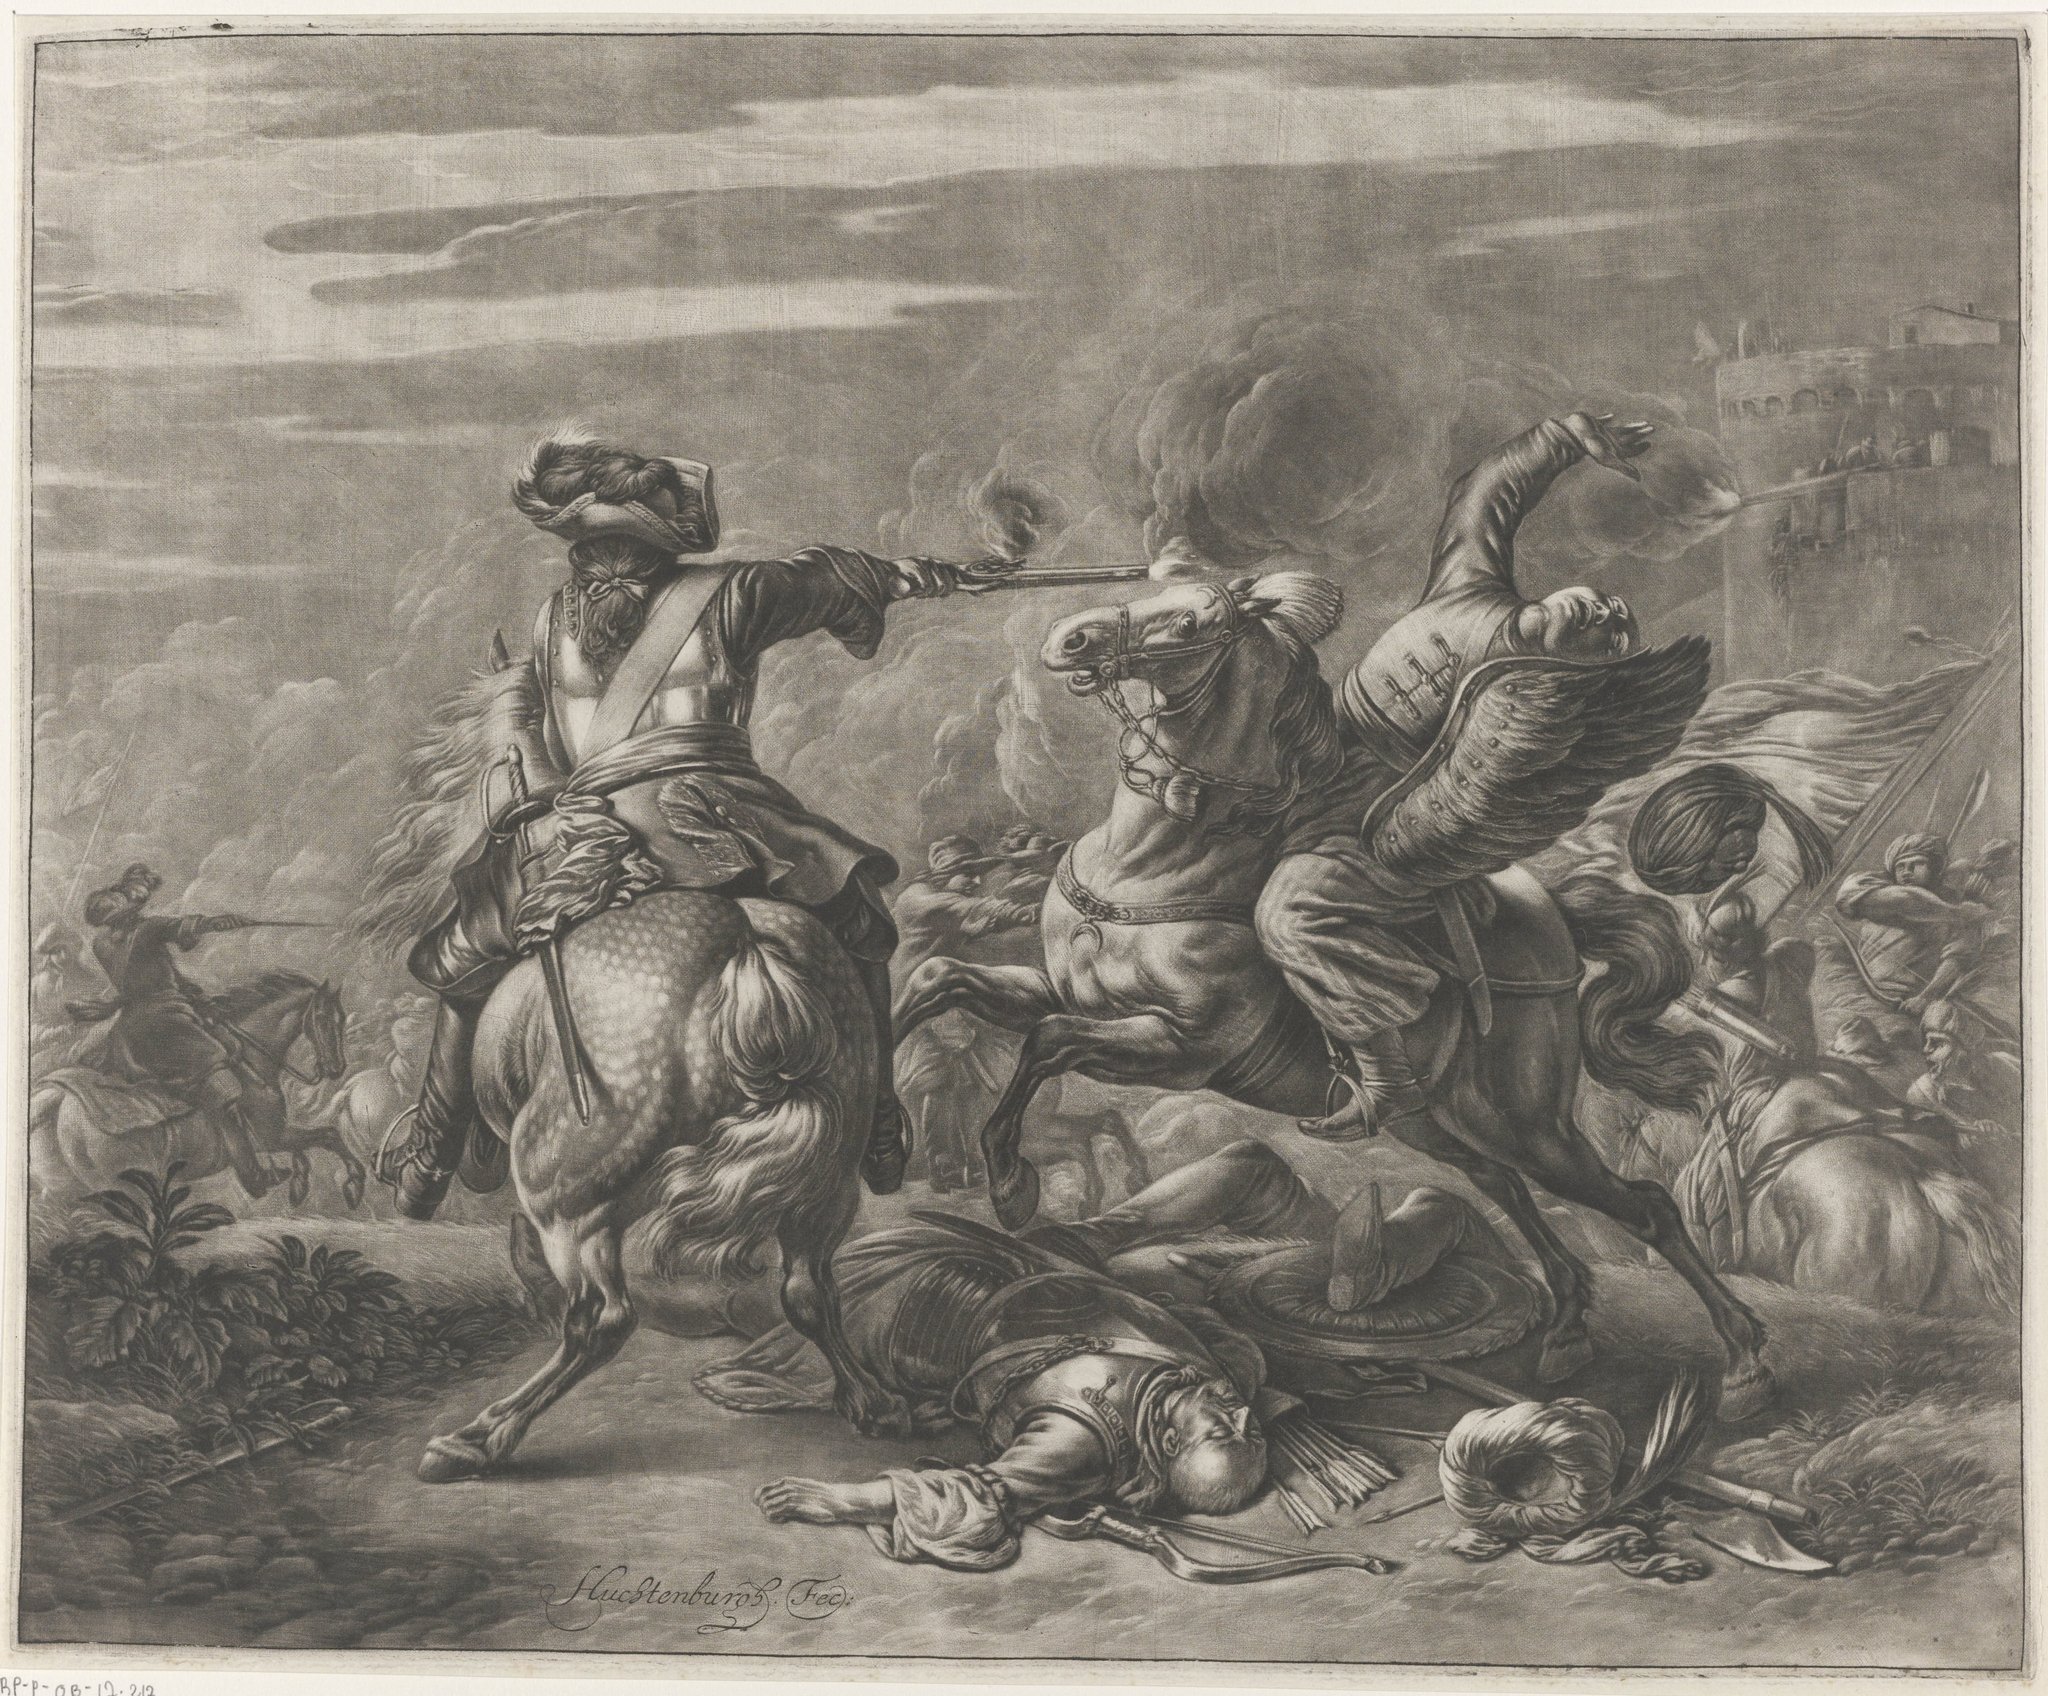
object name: print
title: Ruitergevecht bij een burcht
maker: jan van huchtenburg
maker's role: draughtsman, painter, print maker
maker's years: 1647-1733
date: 1657-1733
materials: paper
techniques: engraving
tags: asiatic races and peoples: turks, battle (+ cavalry, horsemen)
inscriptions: collector's mark: Lugt 240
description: Een ruiter schiet een Turkse krijgsman van zijn paard tijdens een ruitergevecht. Op de grond gewonde en stervende soldaten. Op de achtergrond stijgen rookwolken op boven het slagveld.